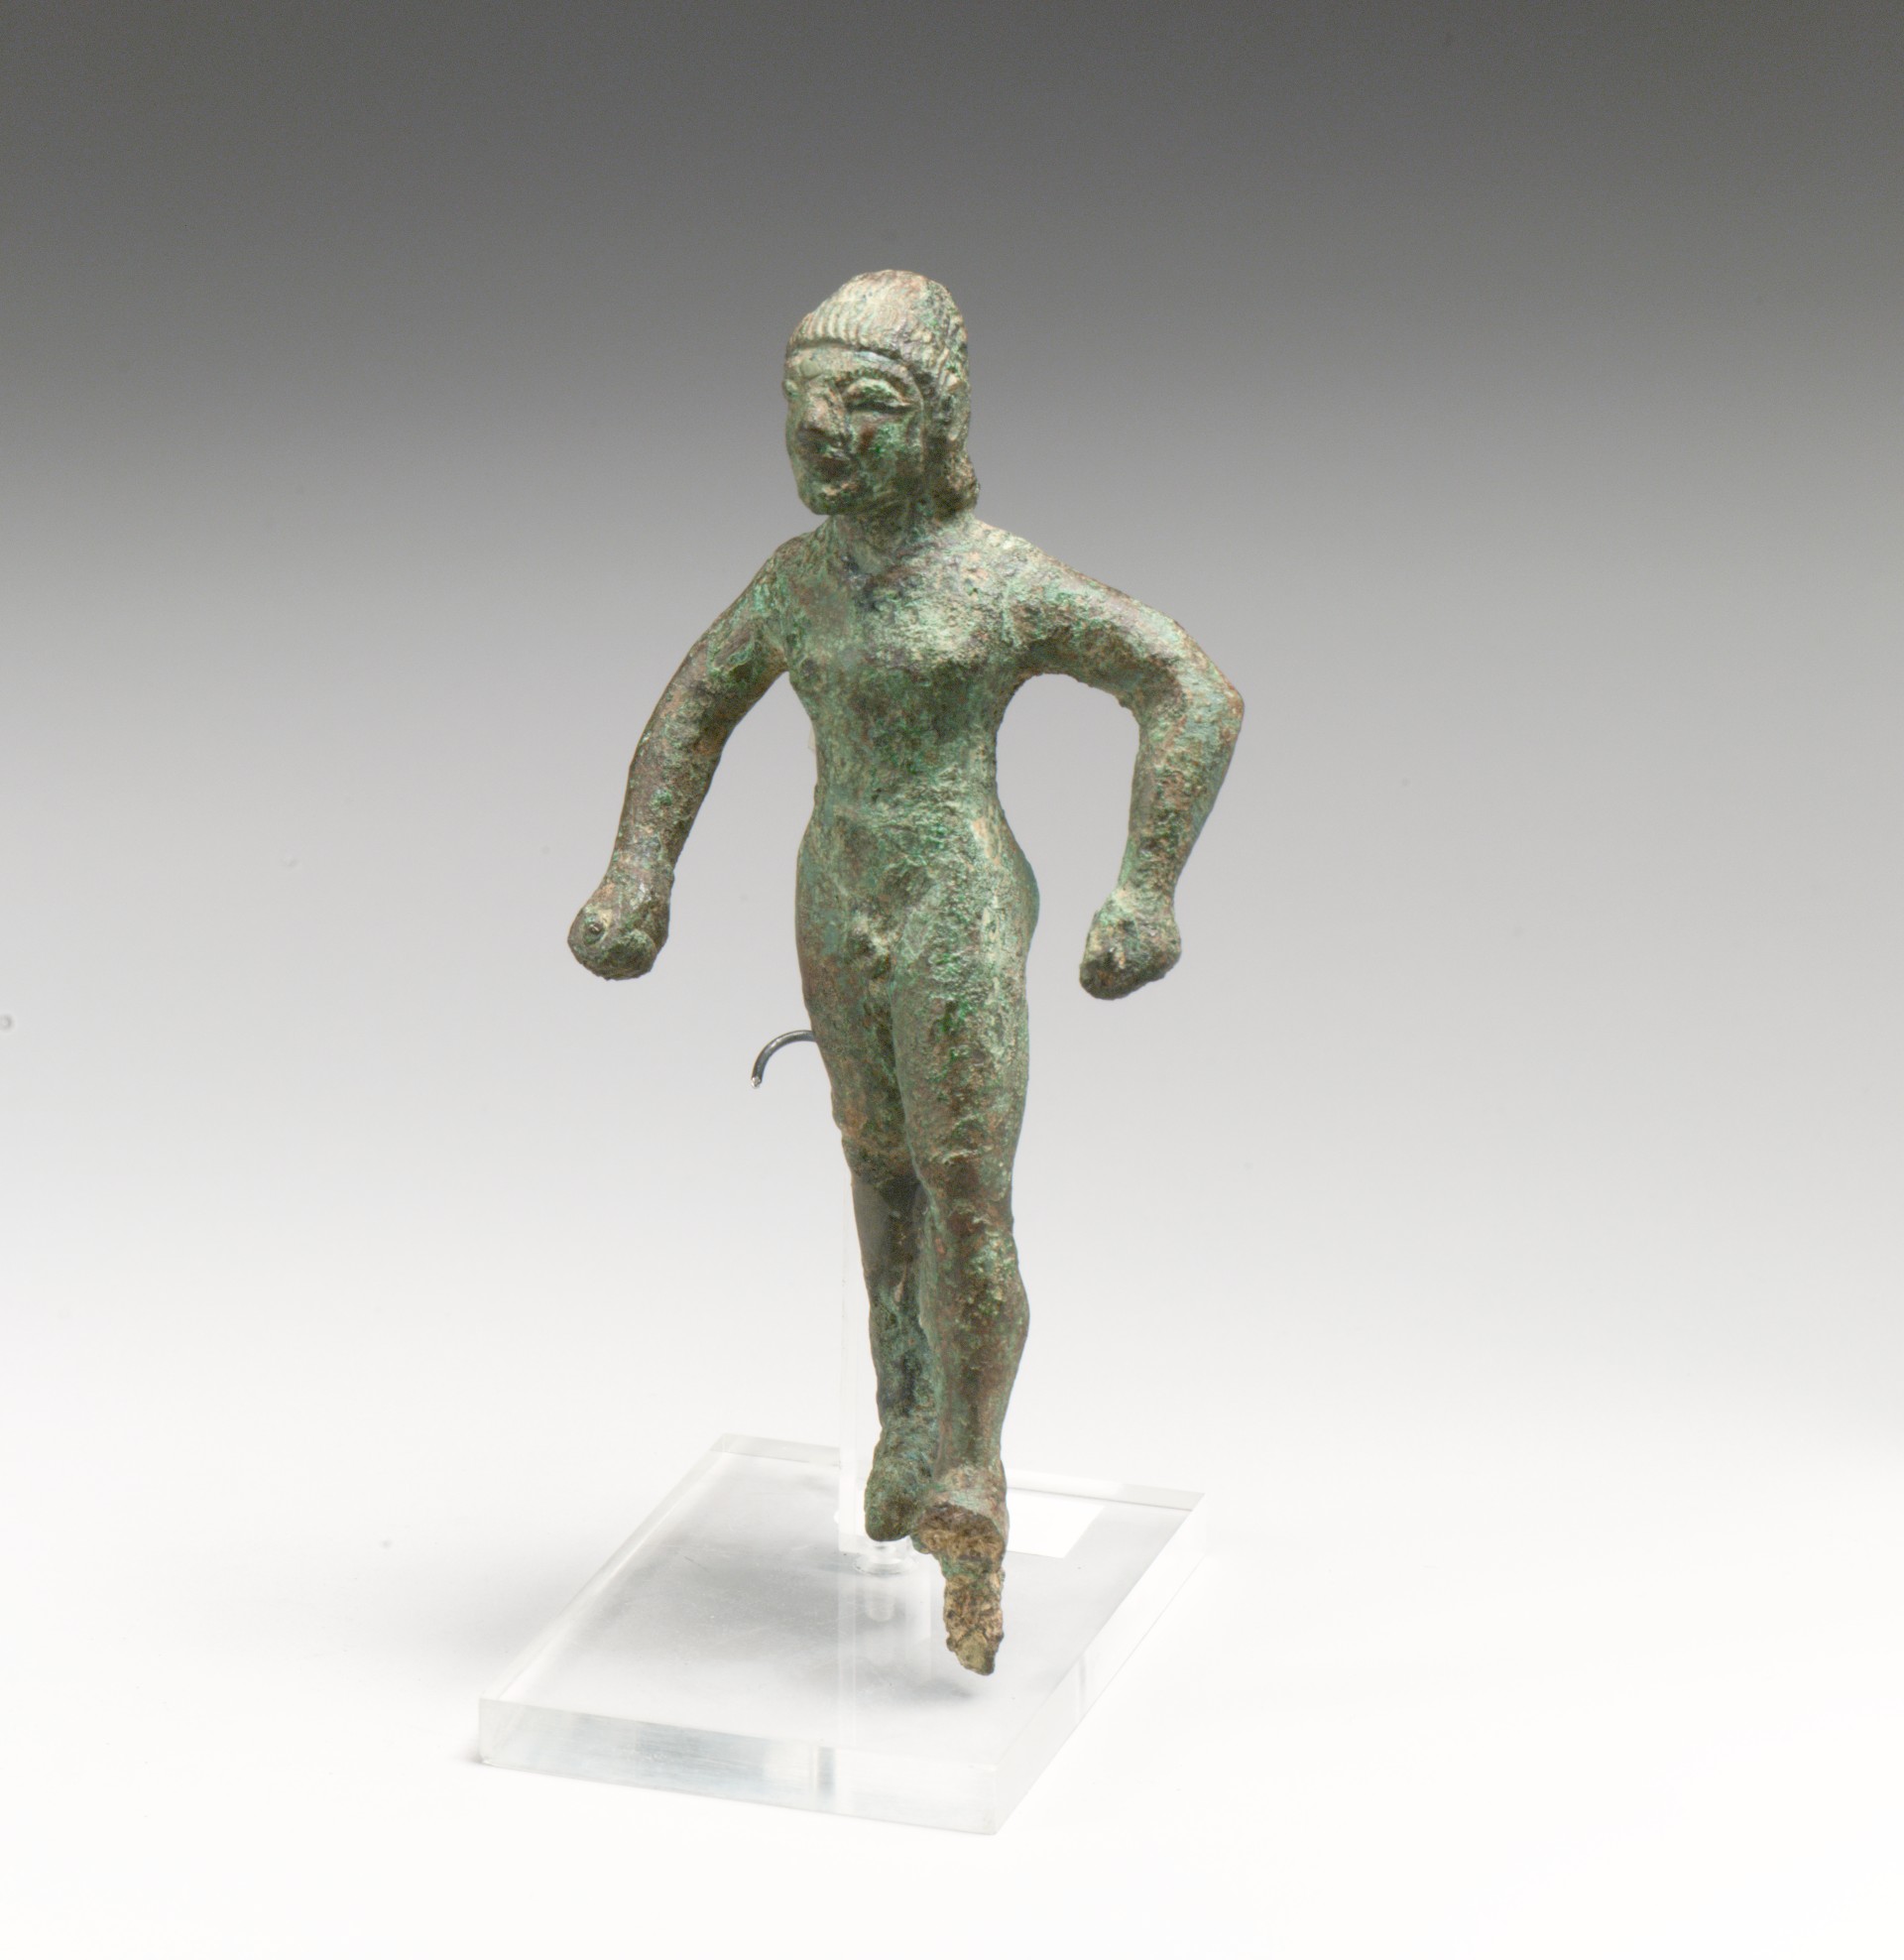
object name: statuette of a youth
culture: etruscan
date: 534-501 BCE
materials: bronze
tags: male nudes